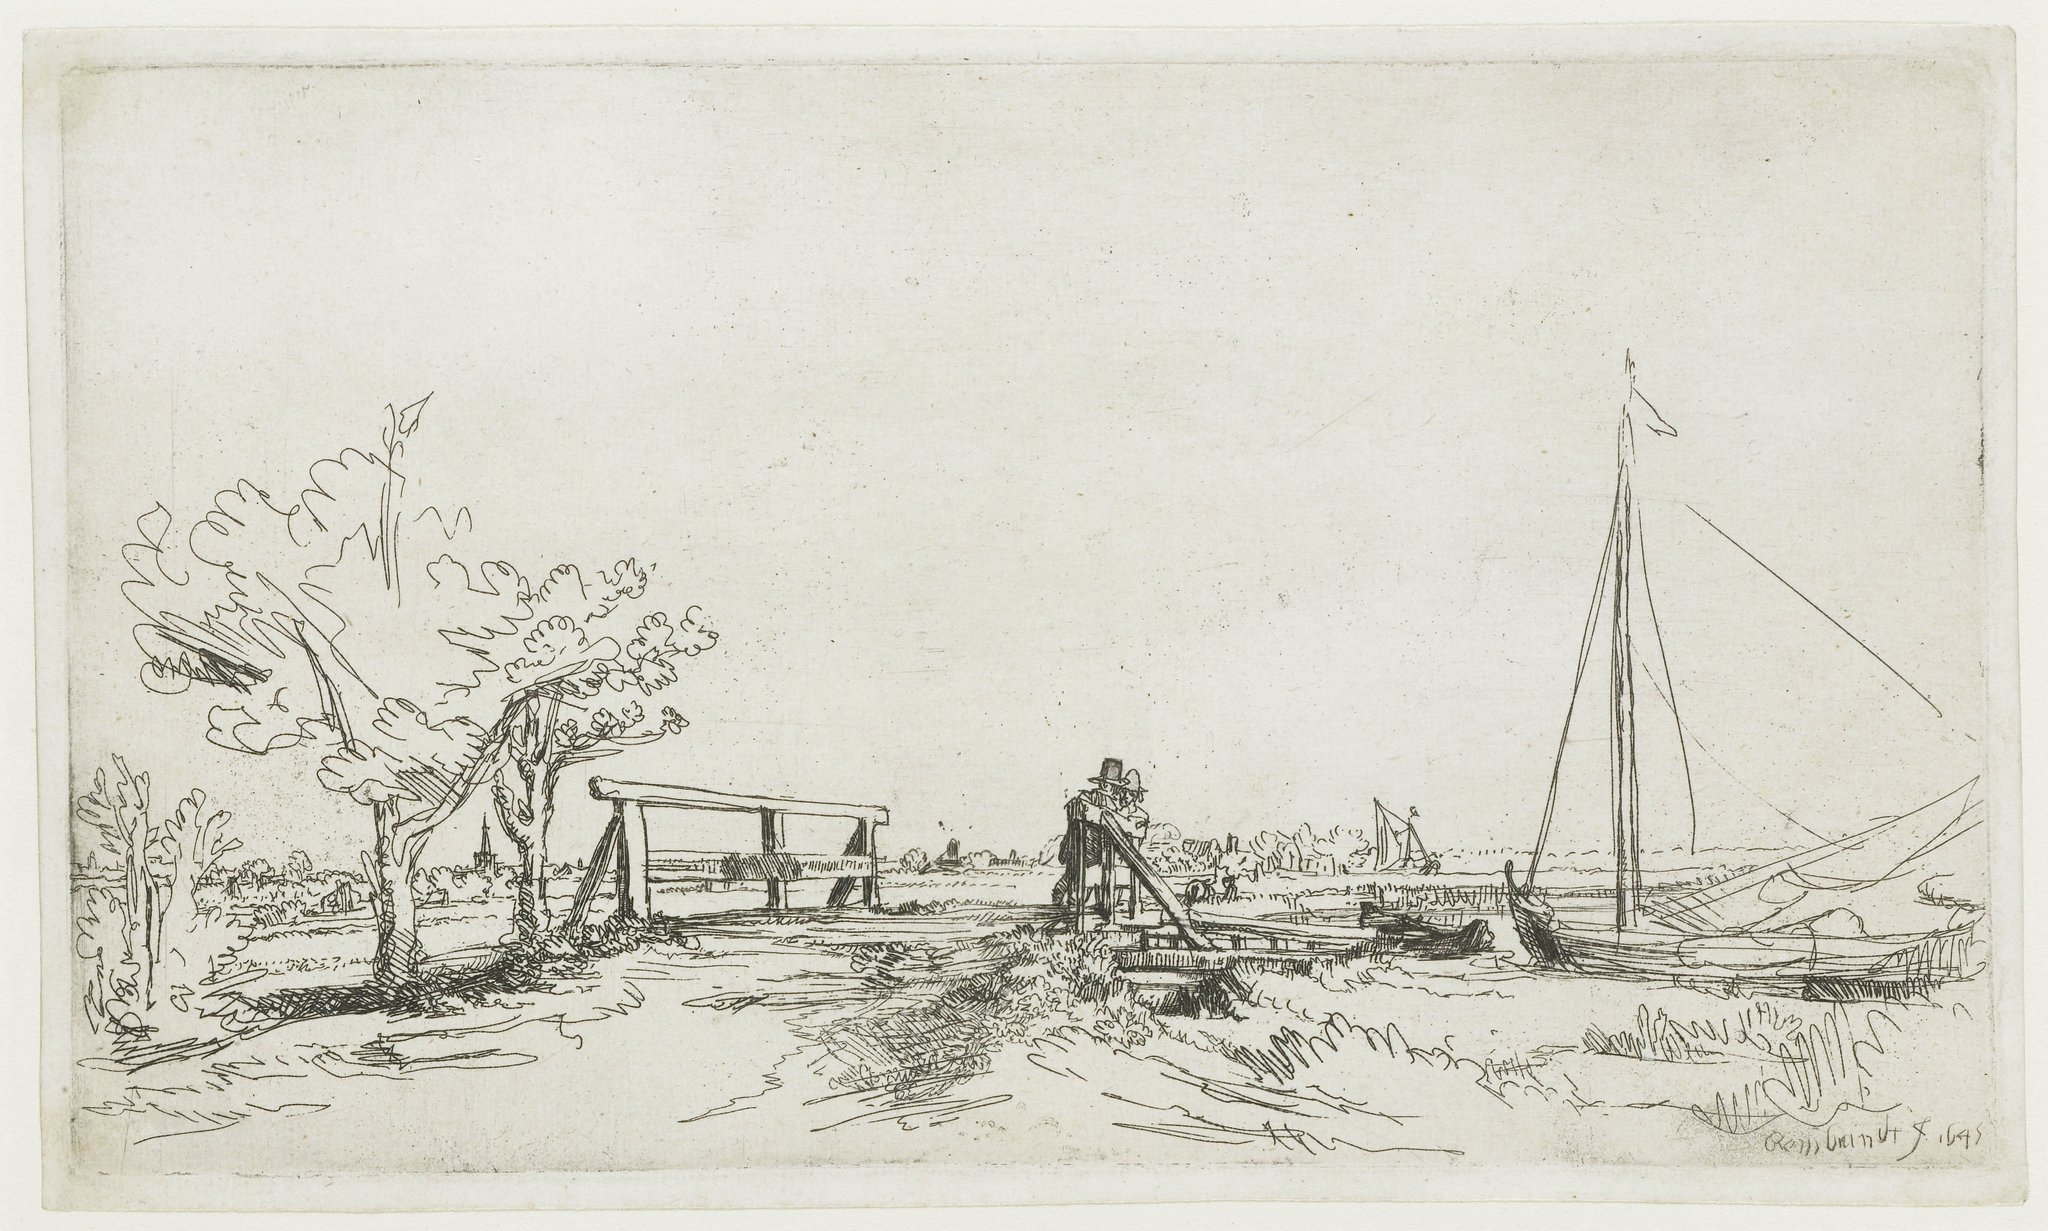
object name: print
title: The bridge at Klein Kostverloren on the Amstel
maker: rembrandt van rijn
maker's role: draughtsman, painter, print maker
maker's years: 1606-1669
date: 1645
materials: paper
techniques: etching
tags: landscape with bridge, viaduct or aqueduct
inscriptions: mark: ‘Gallice 1870’ Lugt 1063, mark: Lugt 2172, signature and date: ‘Rembrandt f 1645’, mark: Lugt 2228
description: According to tradition, this landscape depicts a view from Jan Six’s country estate on the River Bullewijk near Ouderkerk. Rembrandt would have drawn it on the spot directly into the etching ground while he and Six were waiting for a servant to fetch a pot of mustard. The style suggests that Rembrandt, in any case, did work rapidly. Moreover, it tells us that he went about with prepared copperplates.